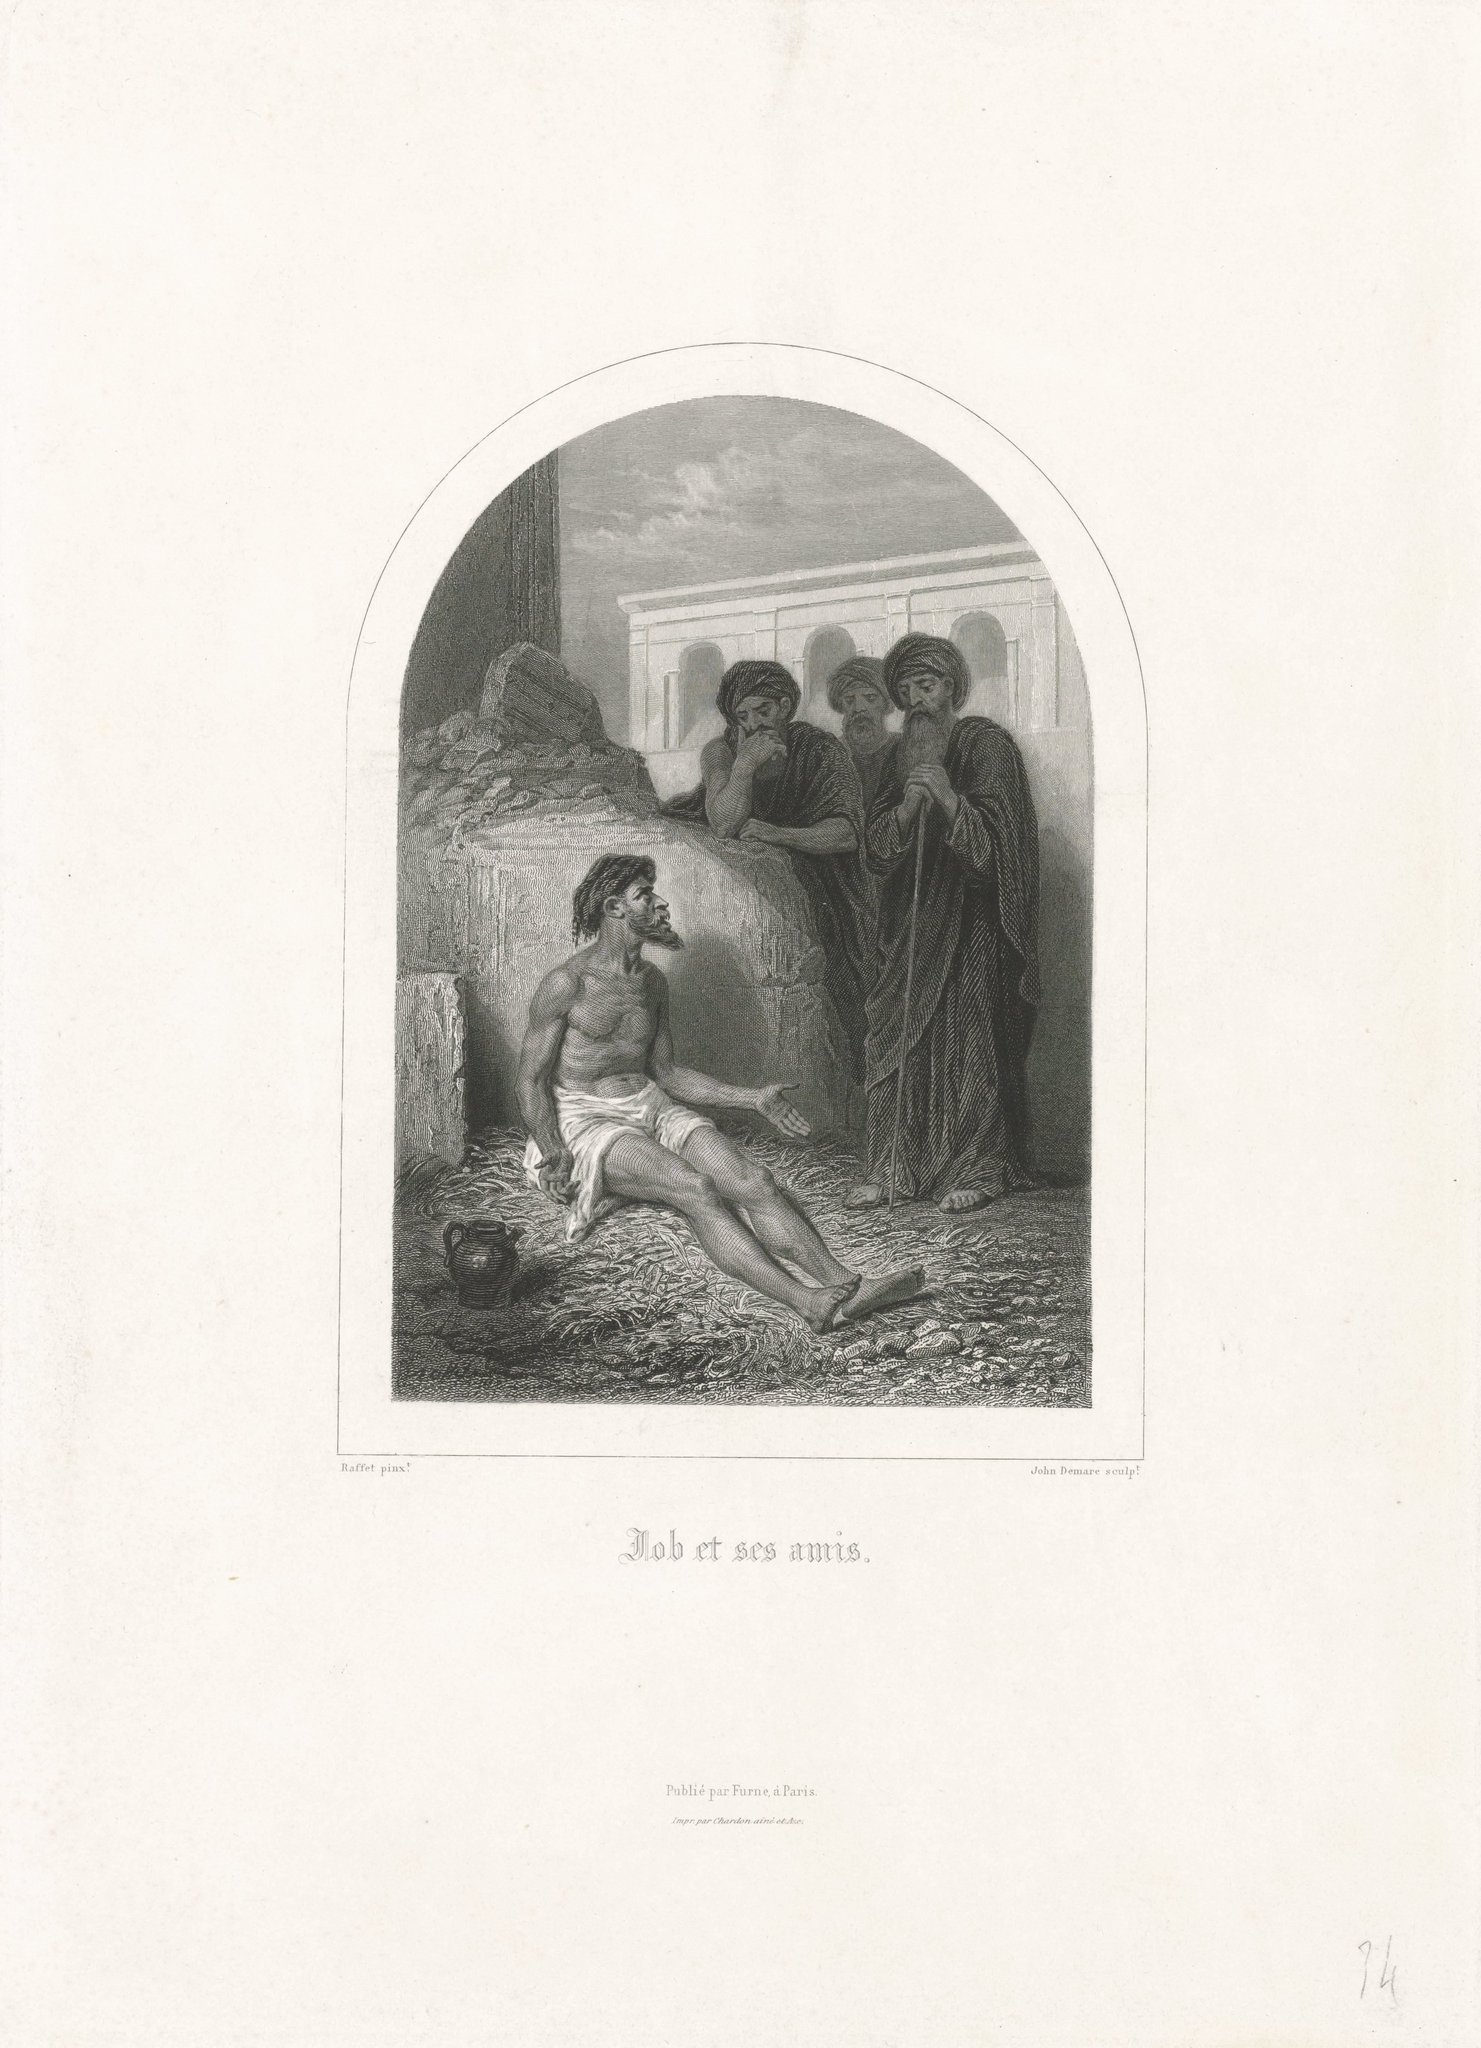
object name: print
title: Job op de mesthoop bezocht door zijn vrienden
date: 1816-1888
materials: paper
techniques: engraving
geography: paris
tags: job on the dunghill (job 2:7-13), job on the dunghill visited by his friends (and wife)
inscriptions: collector's mark: Lugt 2228